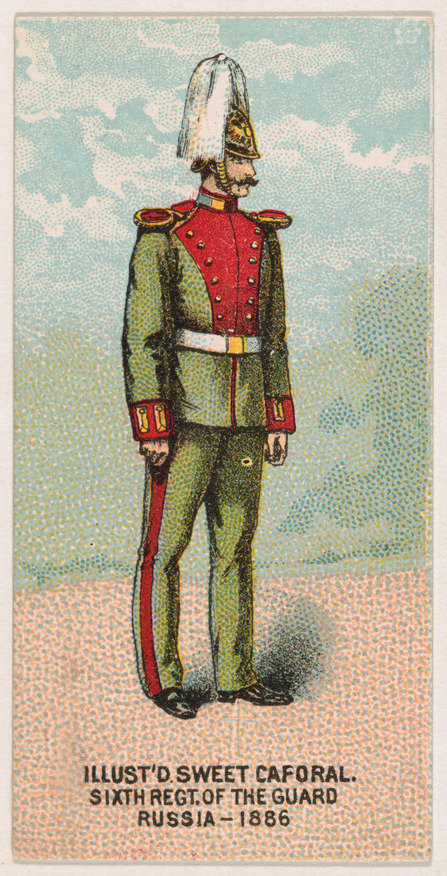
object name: print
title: Sixth Regiment of the Guard, Russia, 1886, from the Military Series (N224) issued by Kinney Tobacco Company to promote Sweet Caporal Cigarettes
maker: kinney brothers tobacco company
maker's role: publisher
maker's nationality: american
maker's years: 1869-2011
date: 1888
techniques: color lithograph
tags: military,men